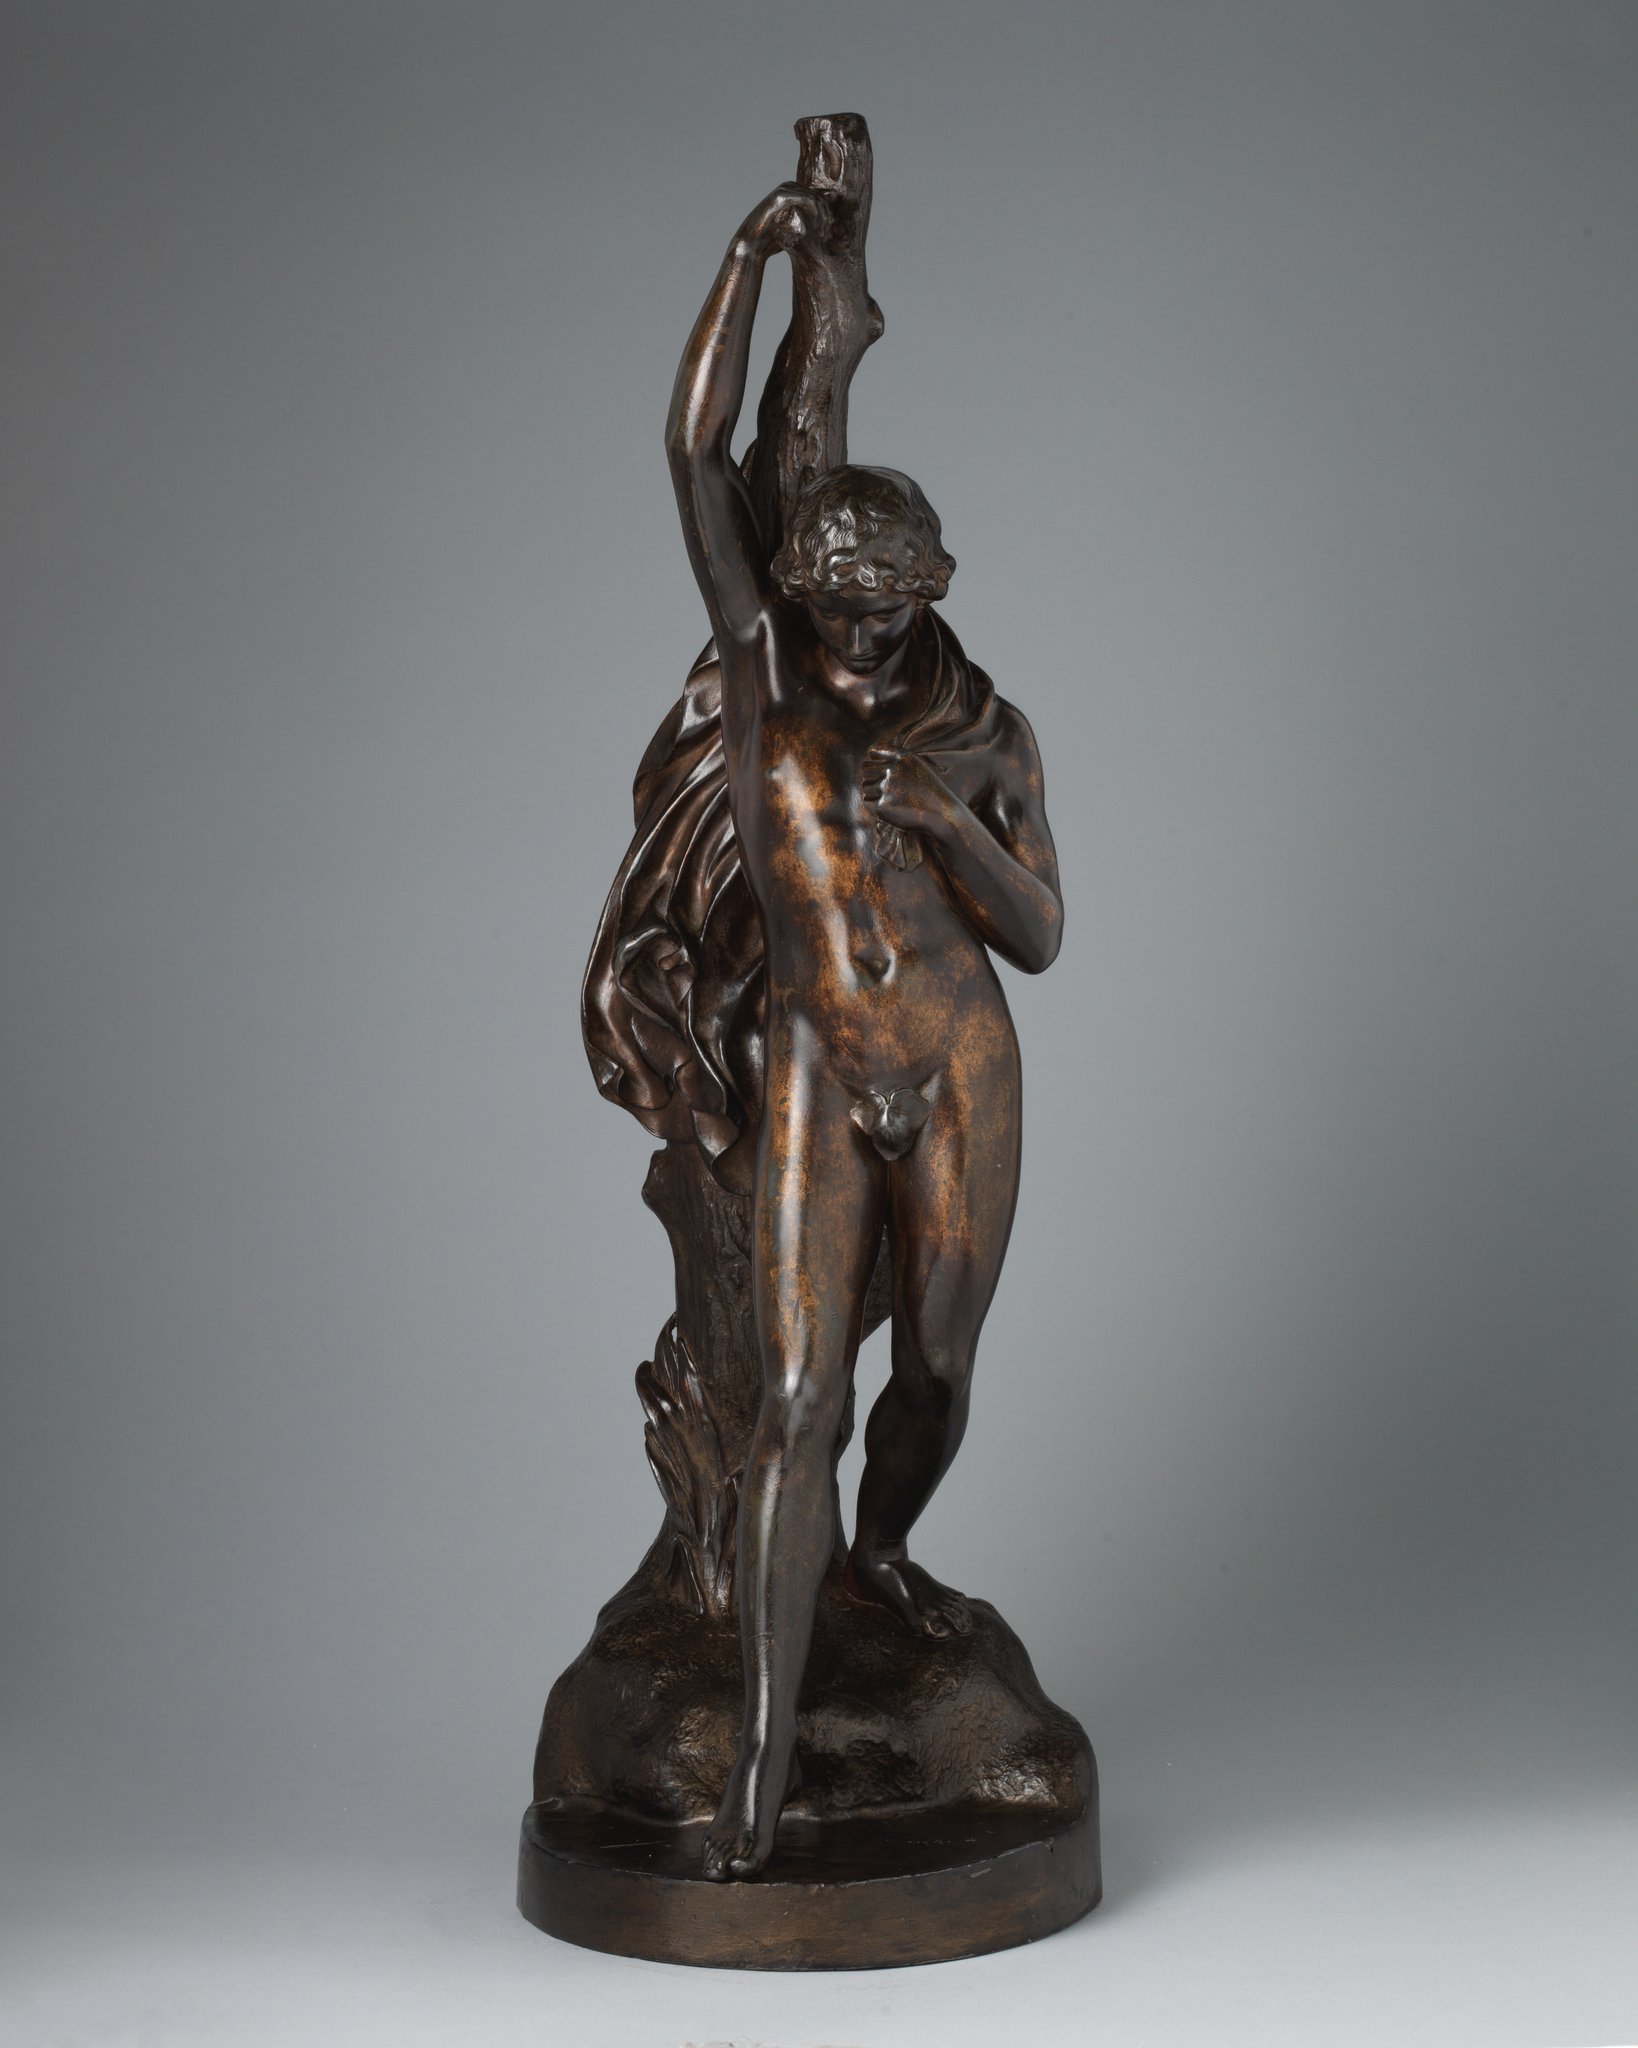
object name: statuette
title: A Youth at a Stream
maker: john henry foley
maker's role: artist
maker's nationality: irish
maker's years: 1818-1874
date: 1844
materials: lacquer, lead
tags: male nudes